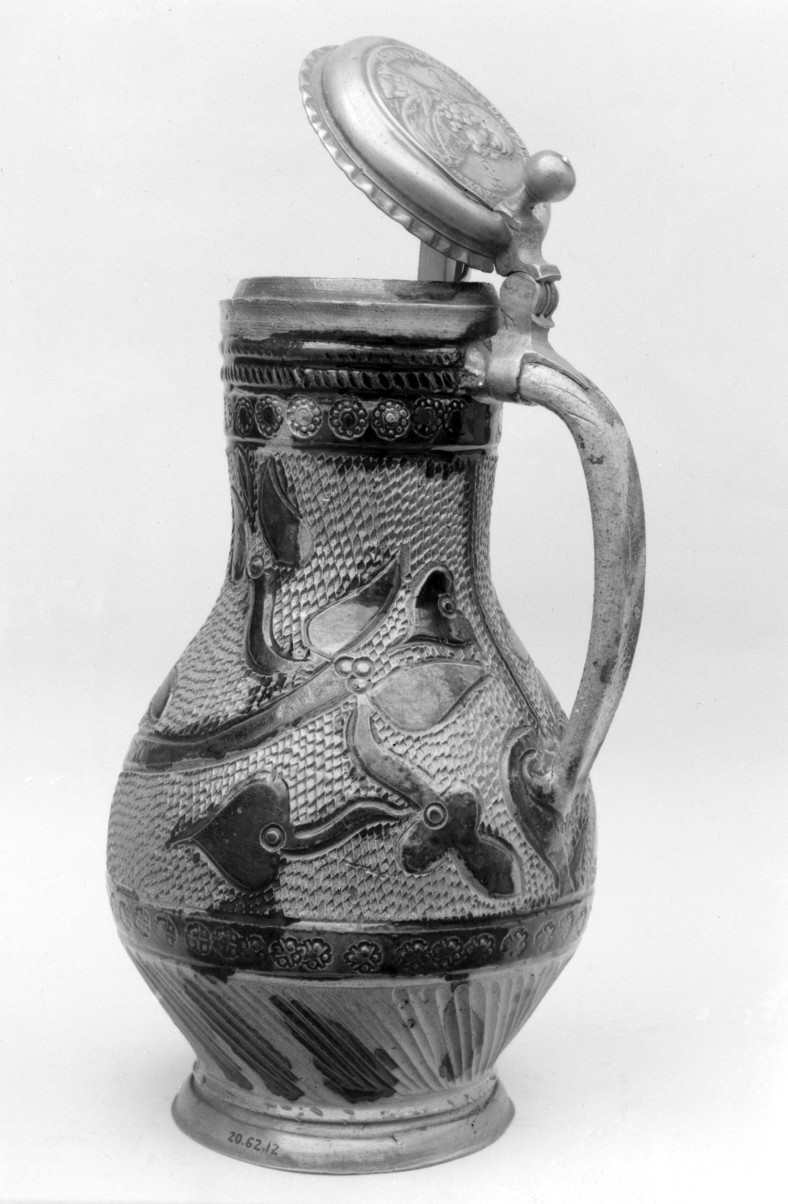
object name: tankard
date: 1651-1700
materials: pewter, stoneware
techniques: salt glaze